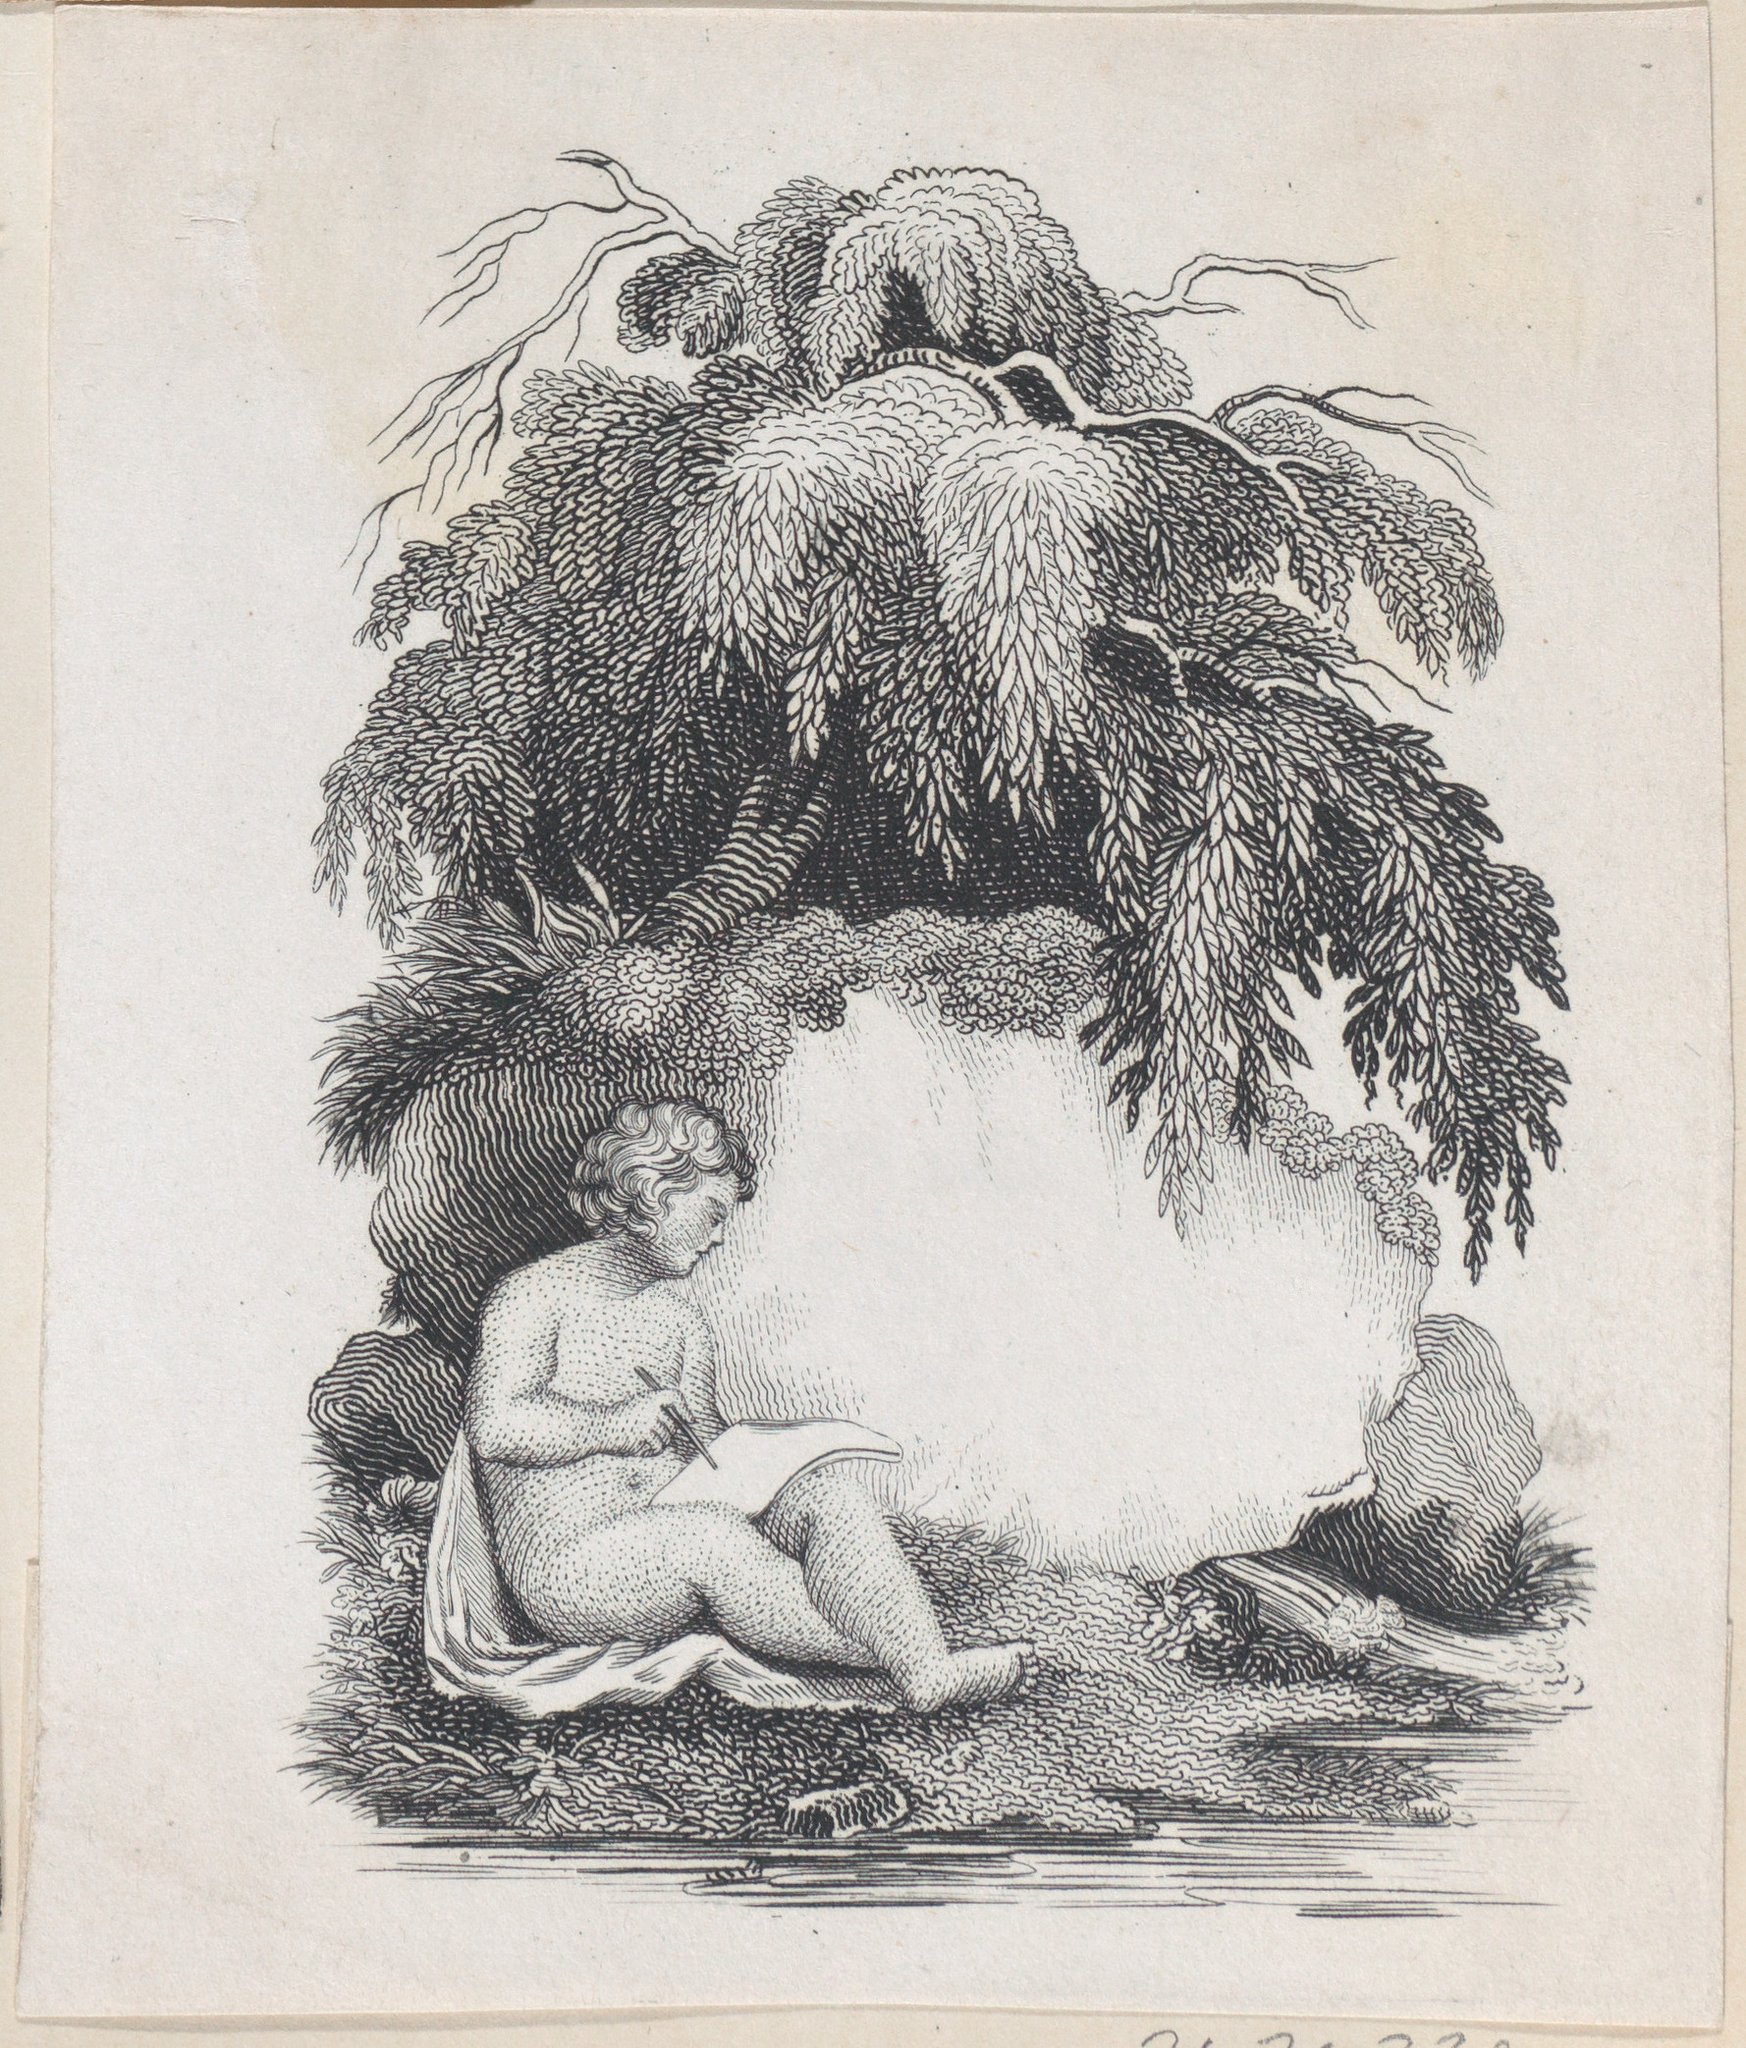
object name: print, trade card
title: Trade Card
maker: anonymous, british, 19th century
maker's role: artist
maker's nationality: british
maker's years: 1800-1900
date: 1801-1900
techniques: engraving